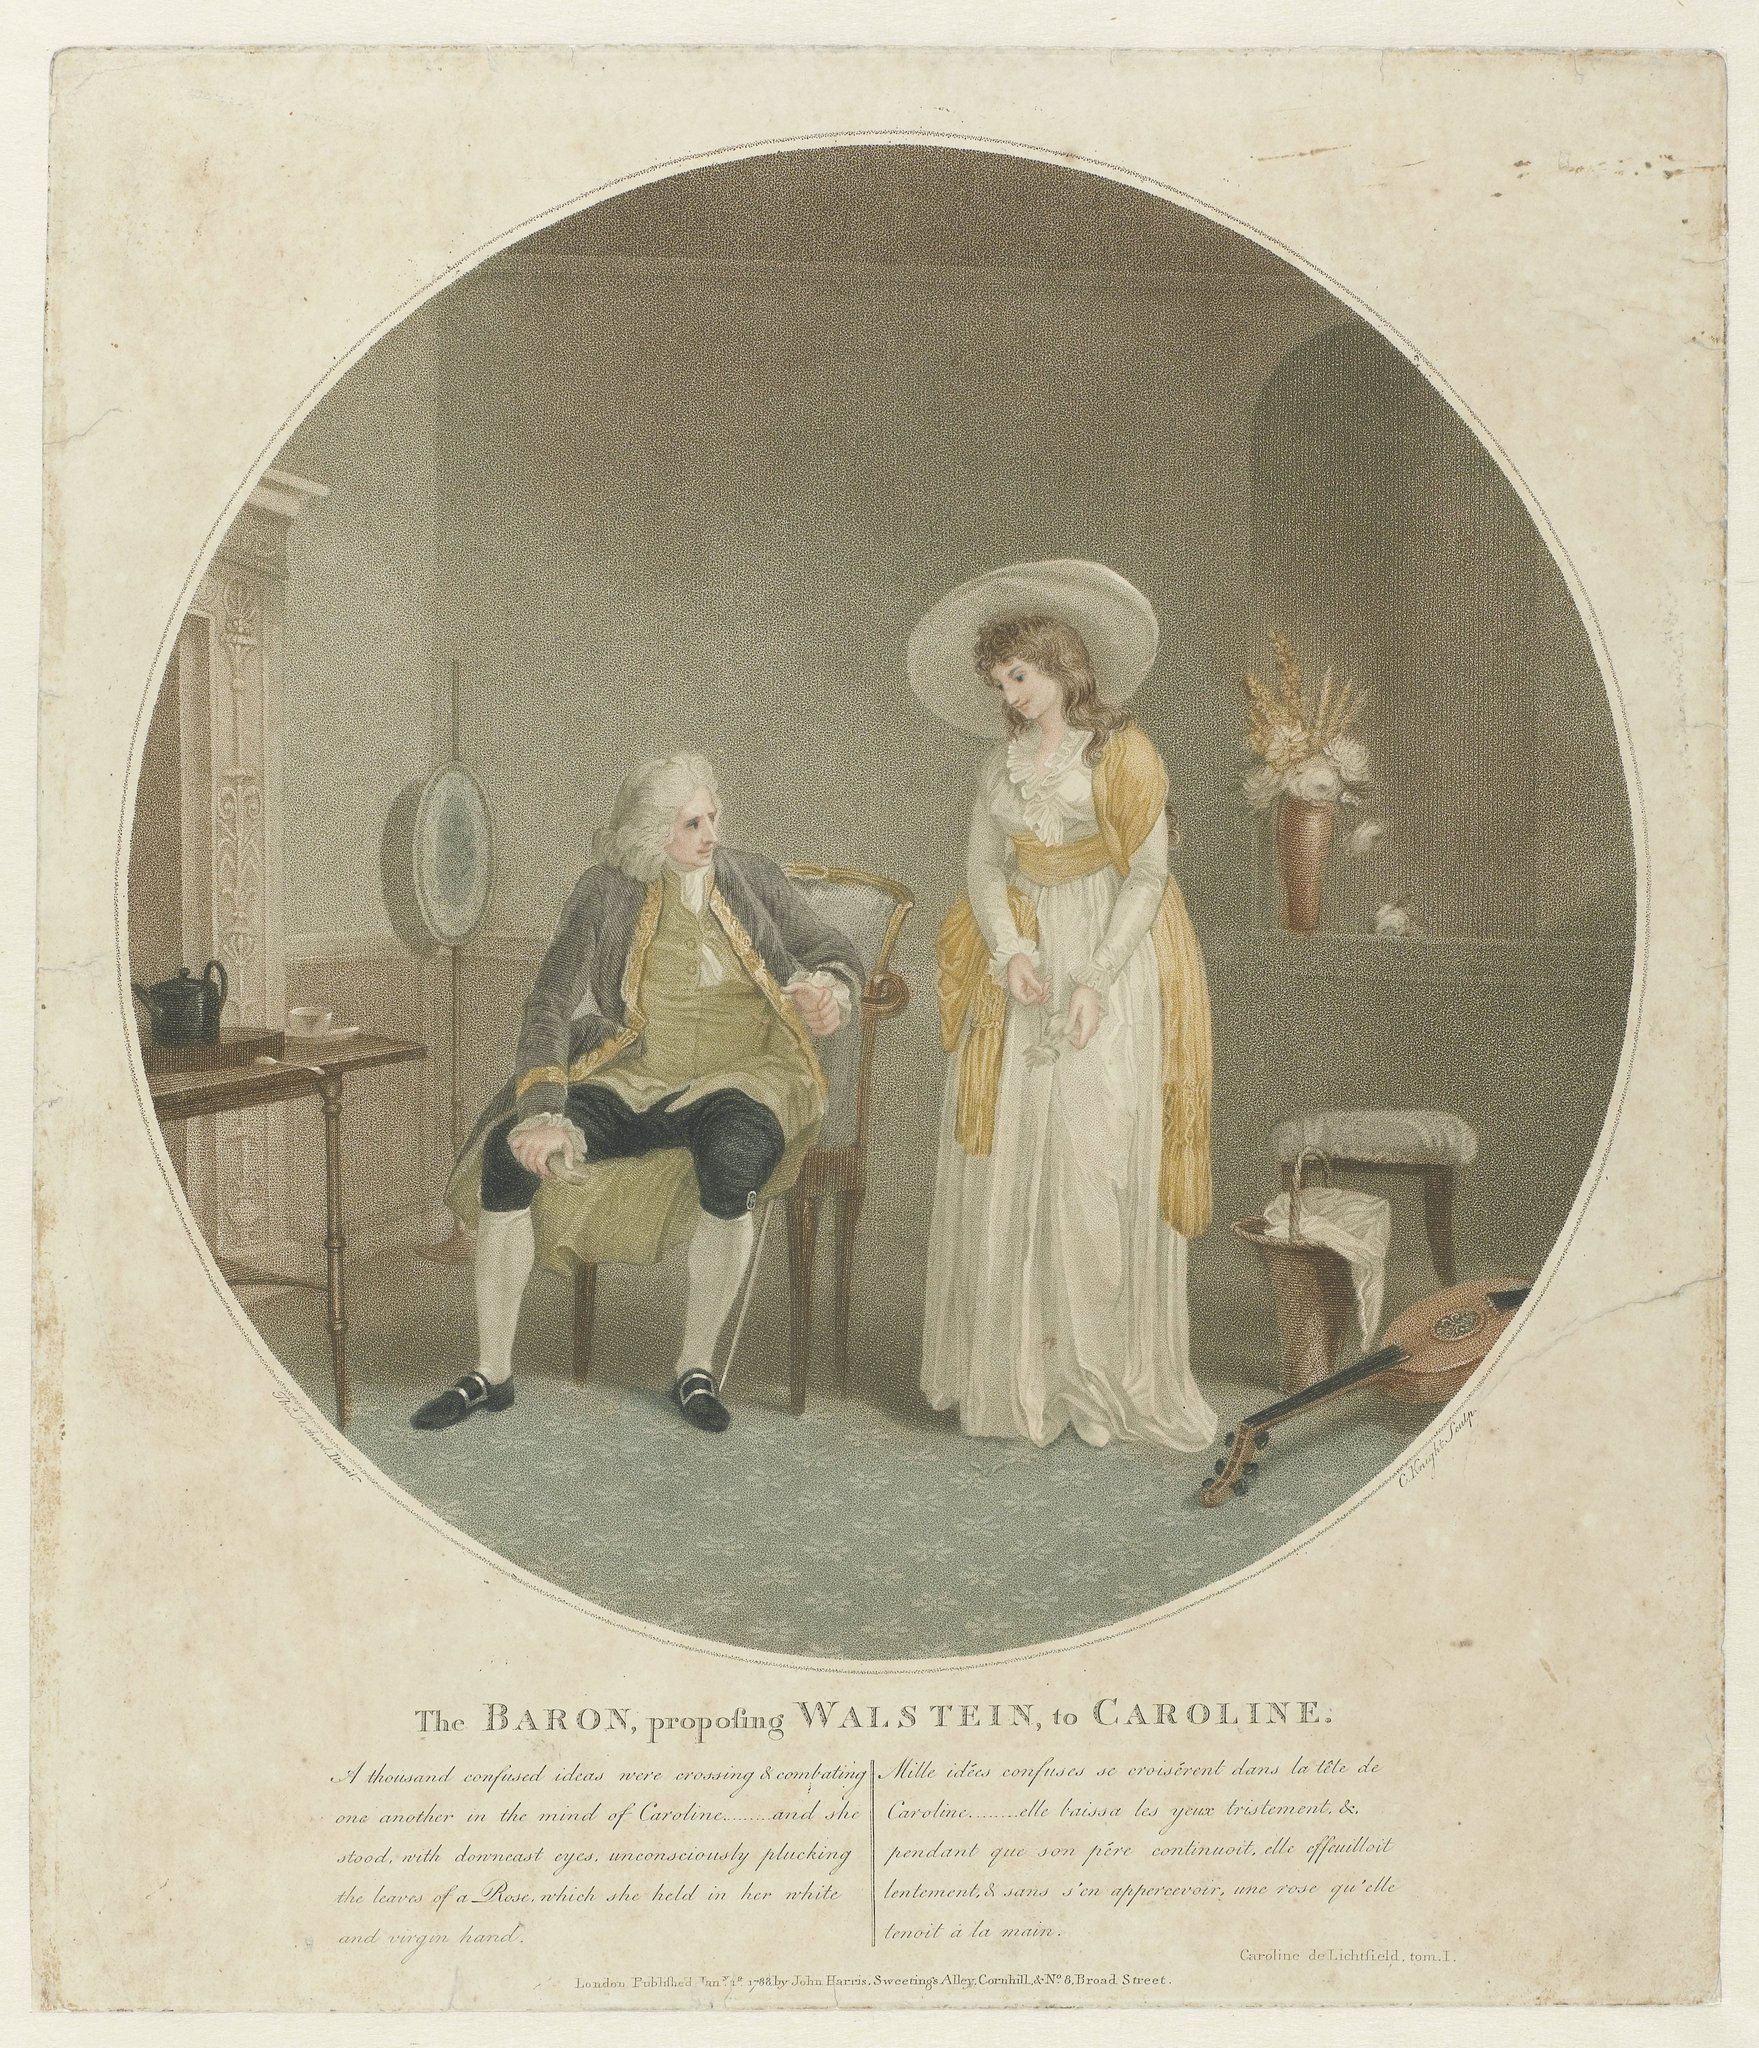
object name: print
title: Vrouw met een witte roos en een man op een stoel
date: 1788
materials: paper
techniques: color etching, stippling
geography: london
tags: proposal, declaration of love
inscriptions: collector's mark: Lugt 2228